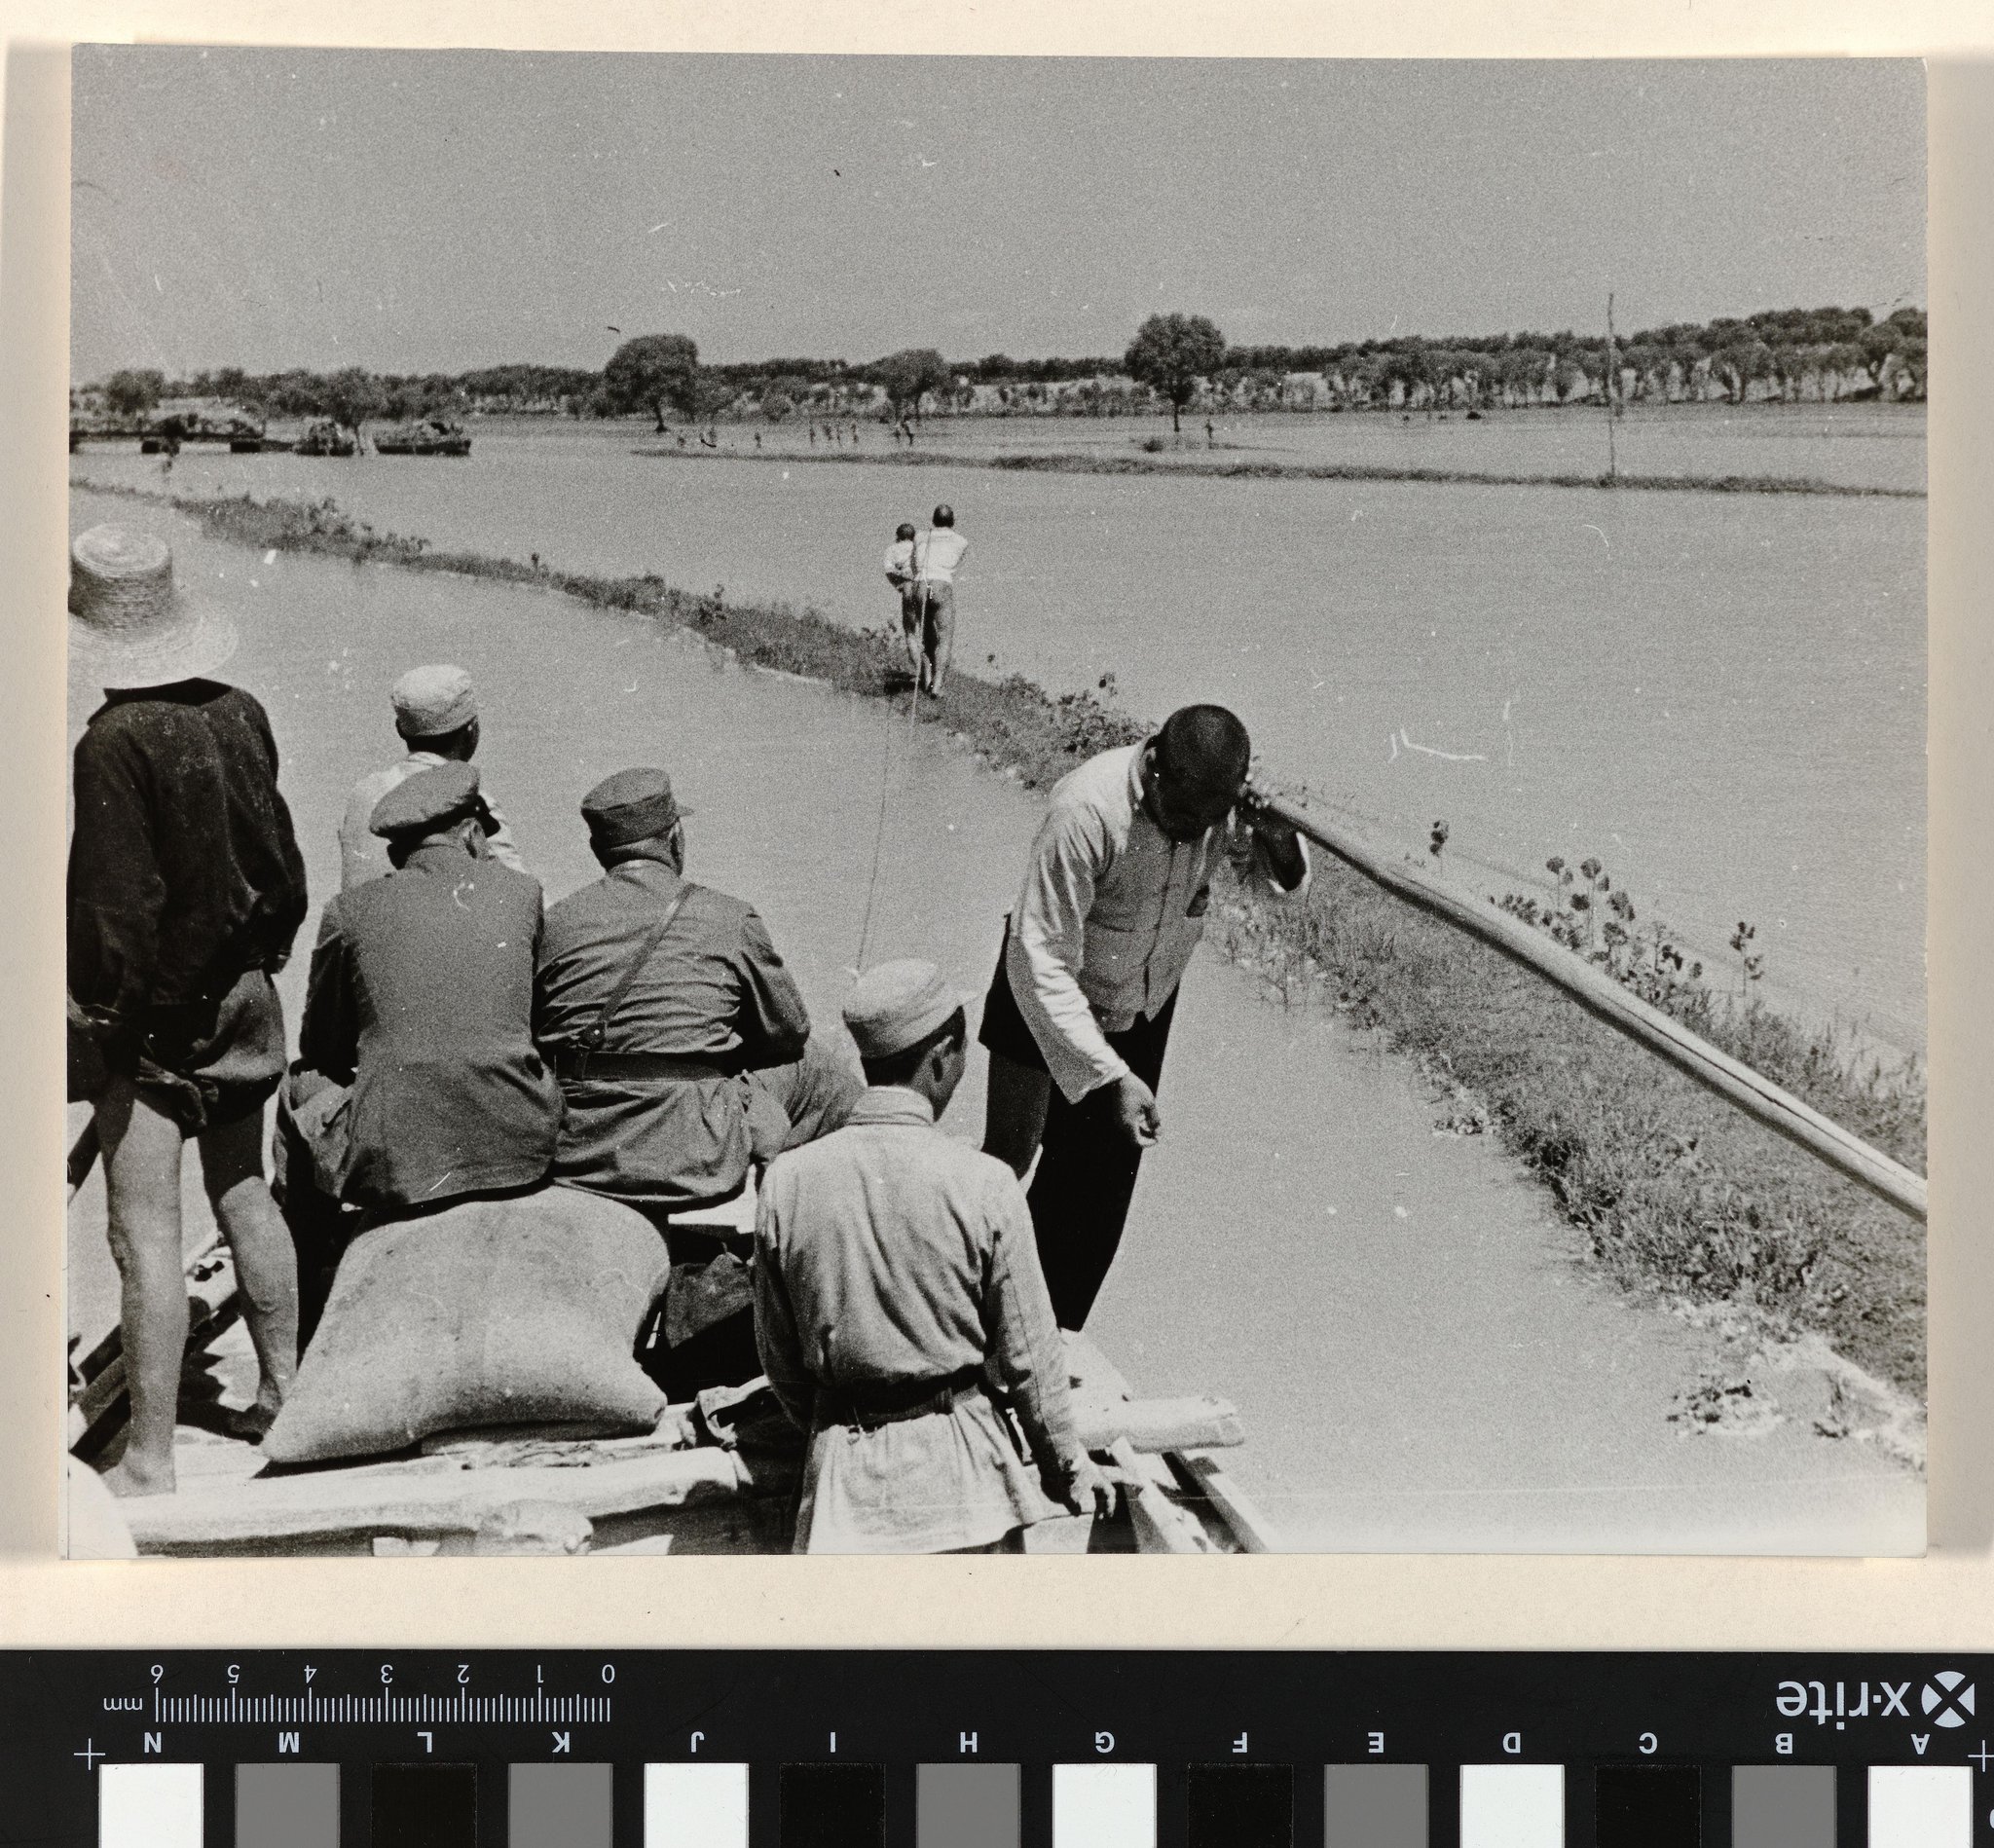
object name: news photograph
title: Barge carrying soldiers through flooded area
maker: robert capa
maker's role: fotograaf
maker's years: 1913-1954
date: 1938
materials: paper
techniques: gelatin silver print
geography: china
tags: tow-boat, towing-barge, china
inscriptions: stamp: ‘PHOTO BY:/ PIX PUBLISHING INC./ 250 PARK AVENUE/ NEW YORK CITY/ TEL.ELDORADO 5-4021/ PLEASE CREDIT ROBERT CAPA - PIX/ THIS PICTURE IS SOLD TO YOU FOR YOUR/ PUBLICATION ONLY AND MUST NOT BE/ LOANED, SYNDICATED OR USED FOR AD-/ VERTISING PURPOSES WITHOUT WRITTEN/ PERMISSION FROM US.’, annotation: ‘dubbel/ 02’